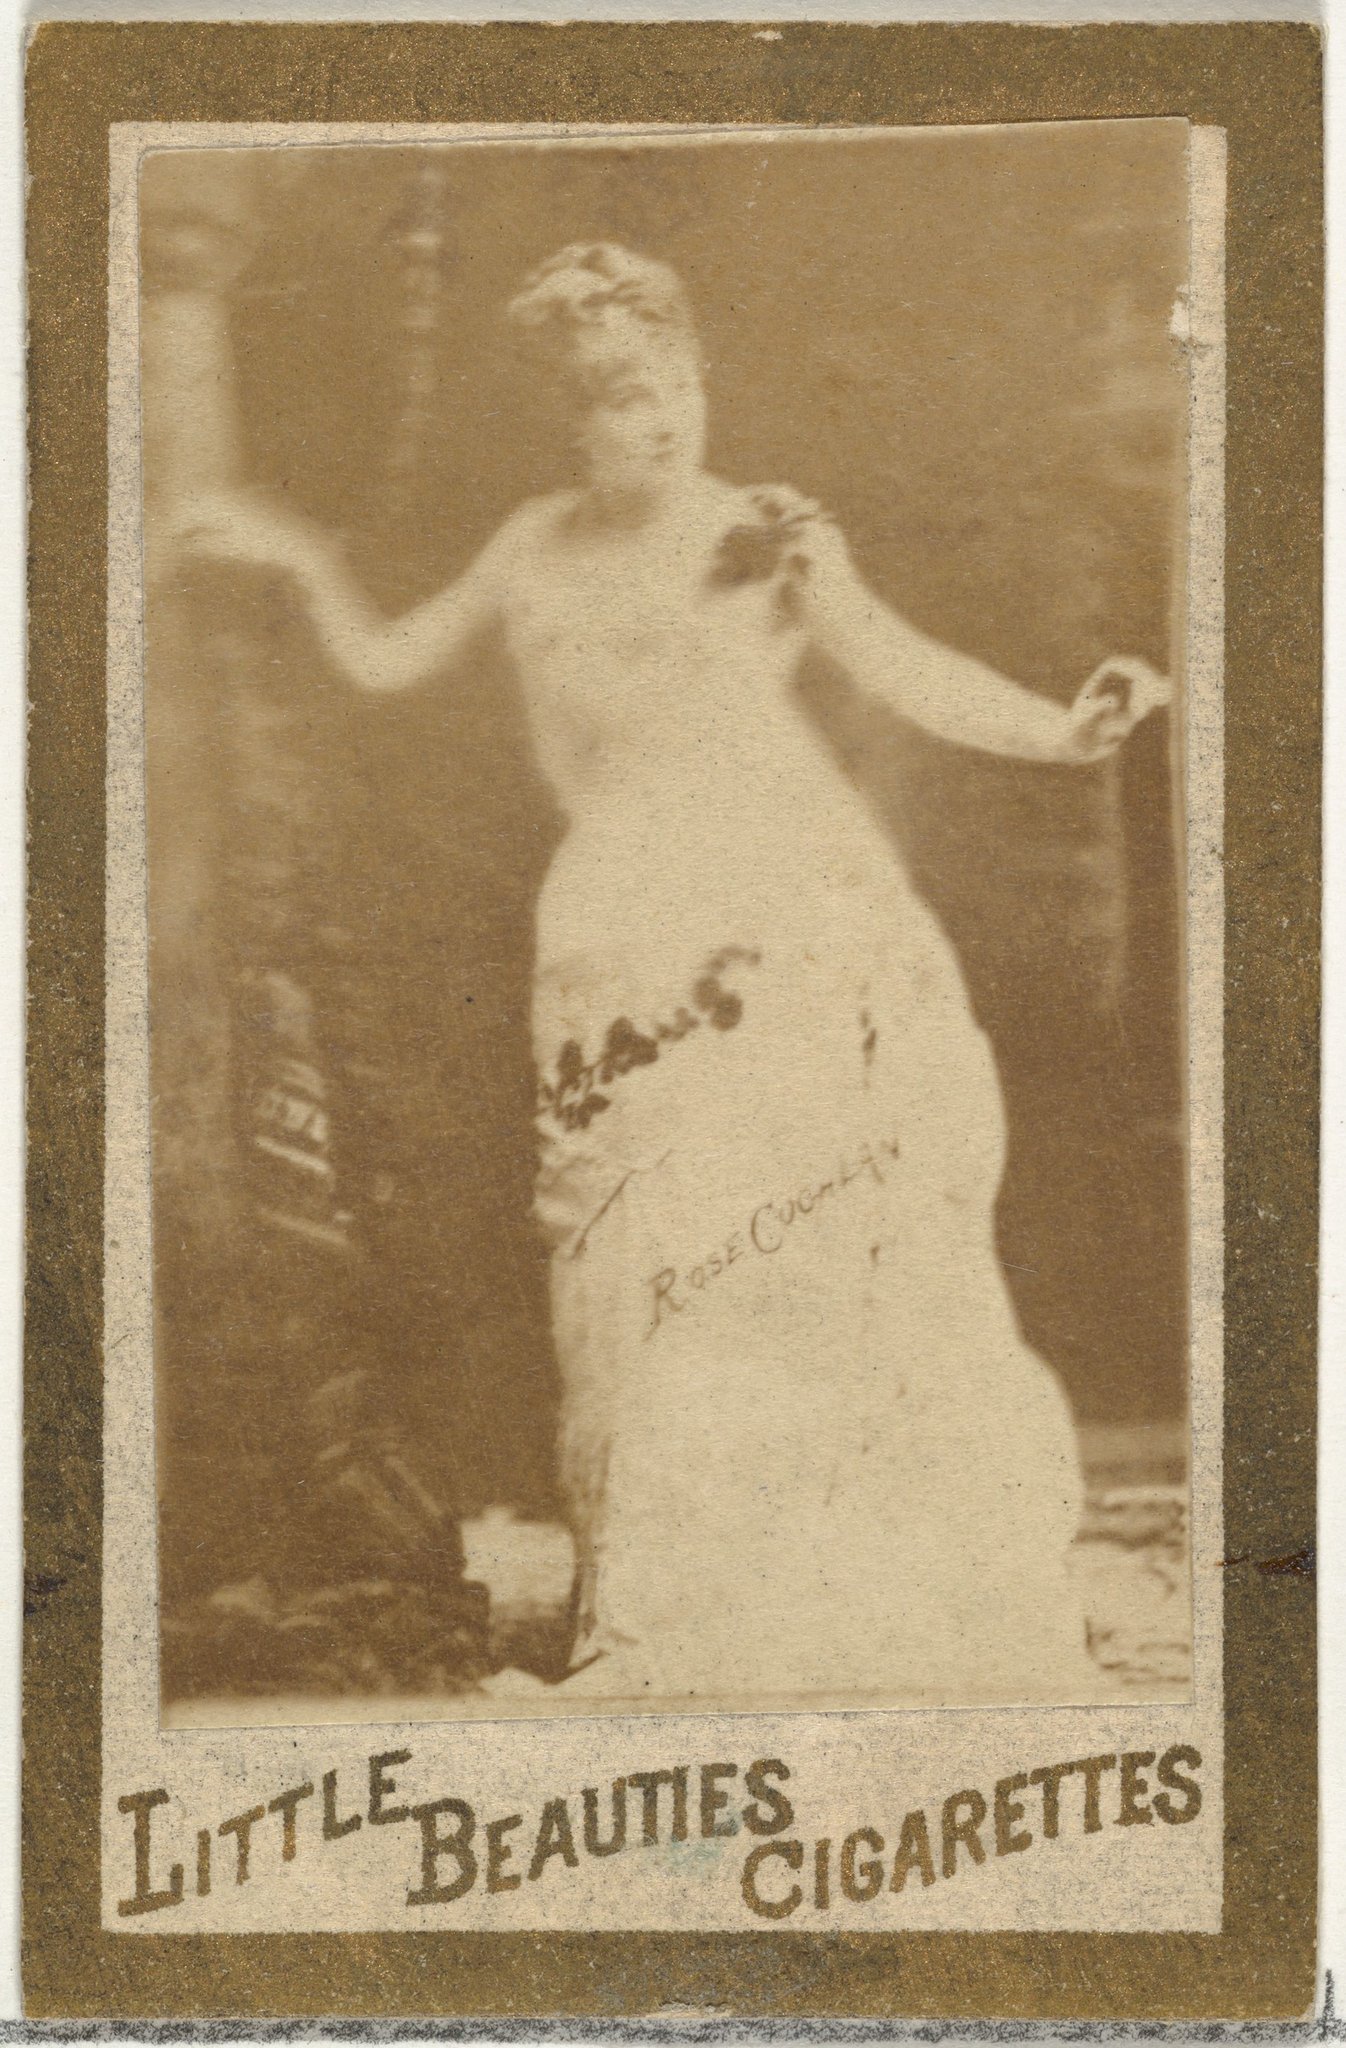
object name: photograph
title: From the Actresses and Celebrities series (N60, Type 1) promoting Little Beauties Cigarettes for Allen & Ginter brand tobacco products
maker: allen & ginter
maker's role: publisher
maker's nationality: american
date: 1887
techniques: albumen silver print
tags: portraits,women,actresses